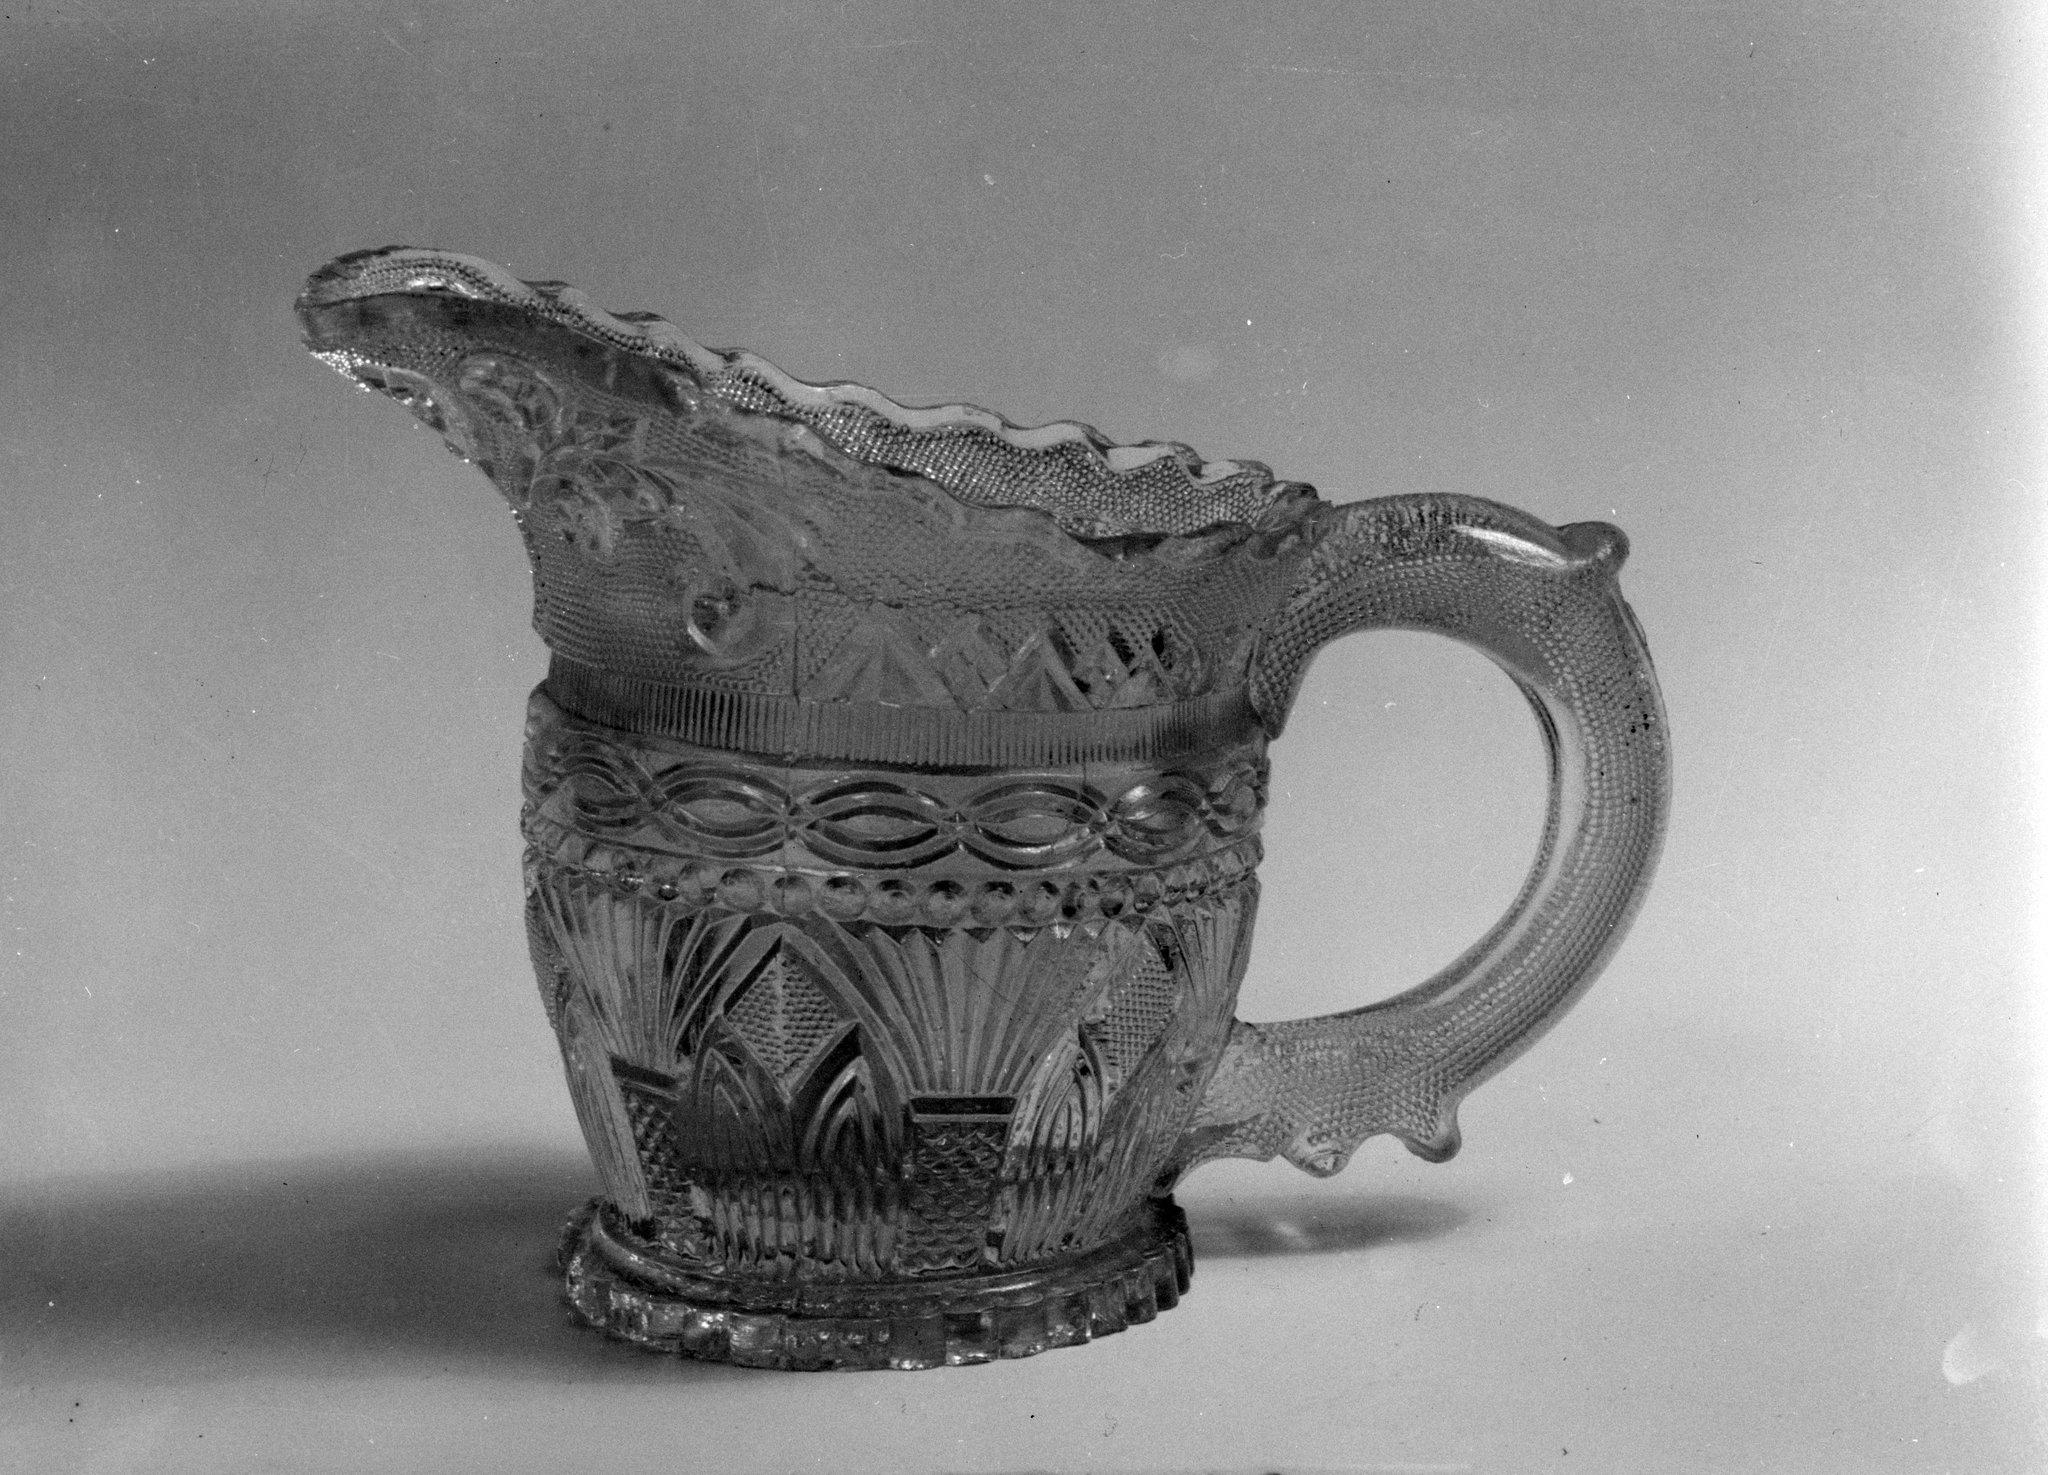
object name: cream pot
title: Creamer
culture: american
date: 1830-1840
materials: glass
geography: united states